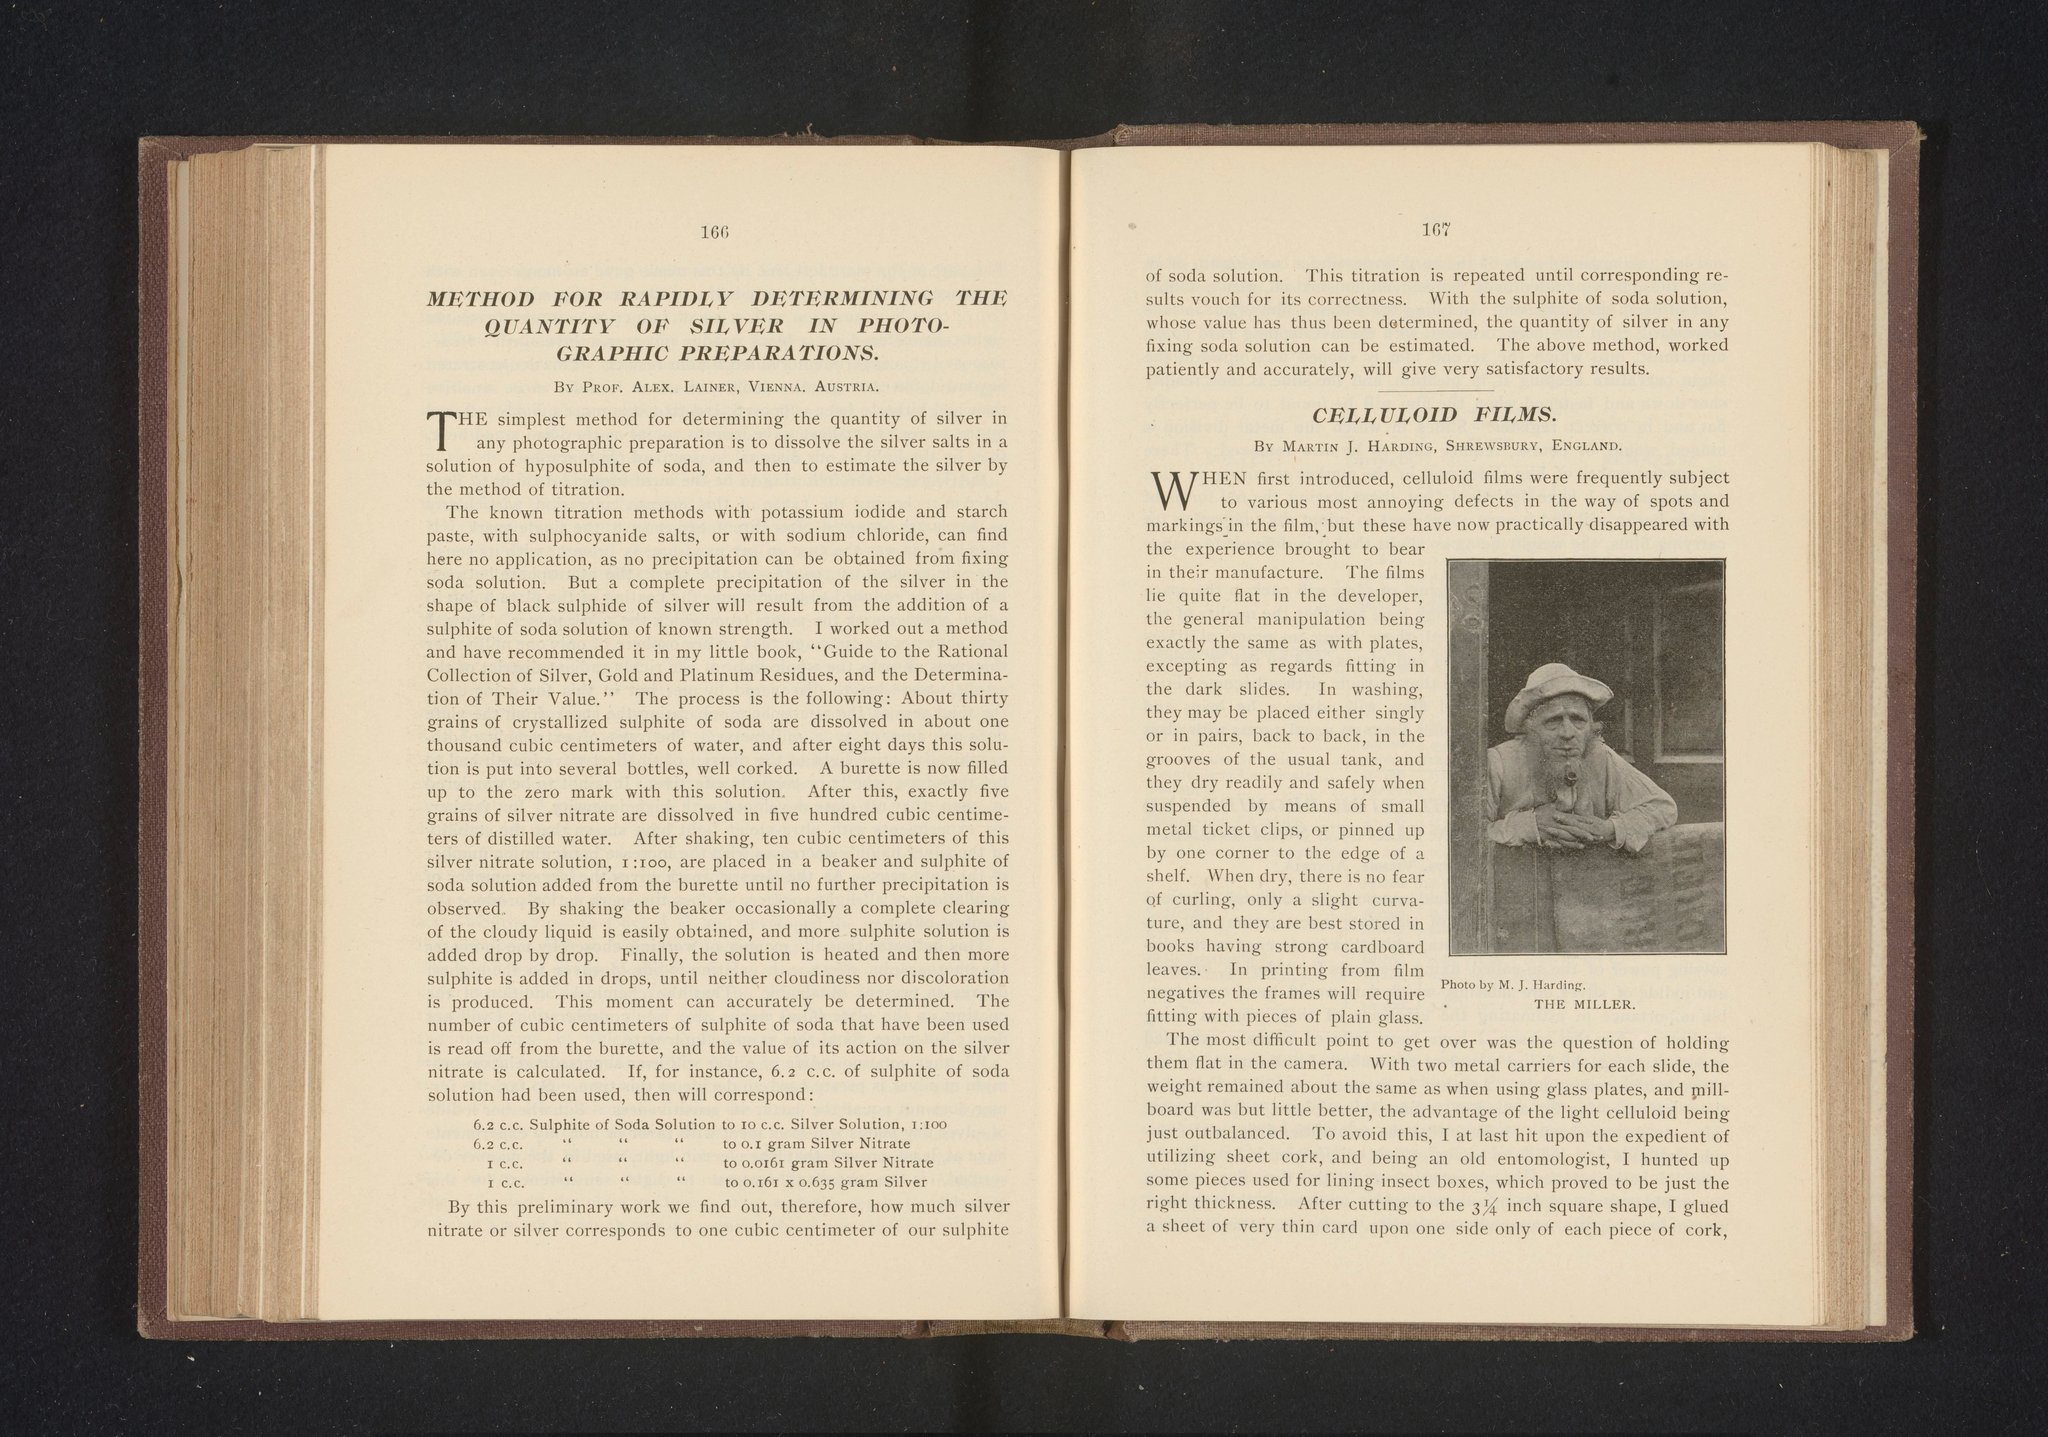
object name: photomechanical print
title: The miller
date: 1890-1895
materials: paper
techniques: autotype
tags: miller